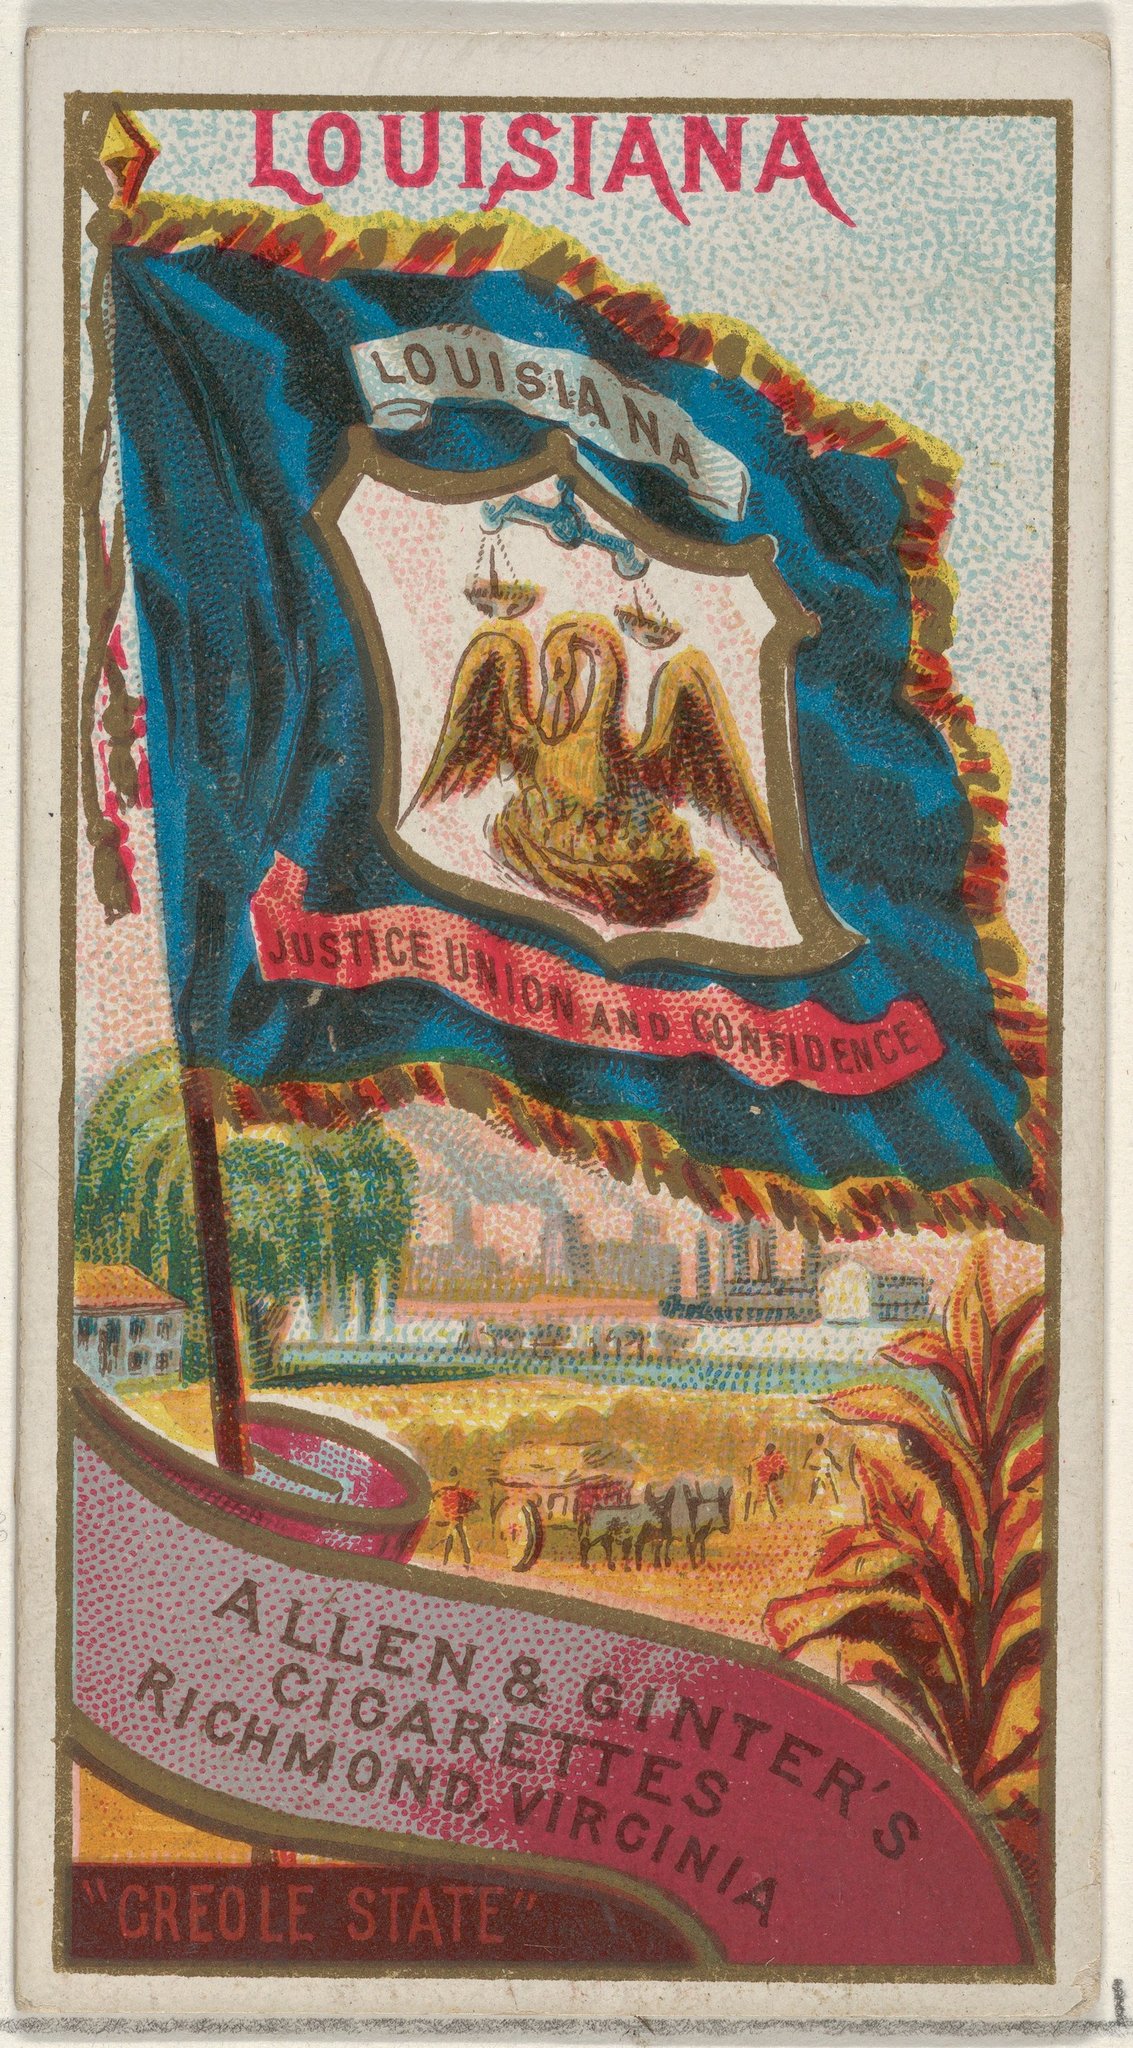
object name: print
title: Louisiana, from Flags of the States and Territories (N11) for Allen & Ginter Cigarettes Brands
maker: allen & ginter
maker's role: publisher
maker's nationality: american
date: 1888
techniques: color lithograph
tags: flags